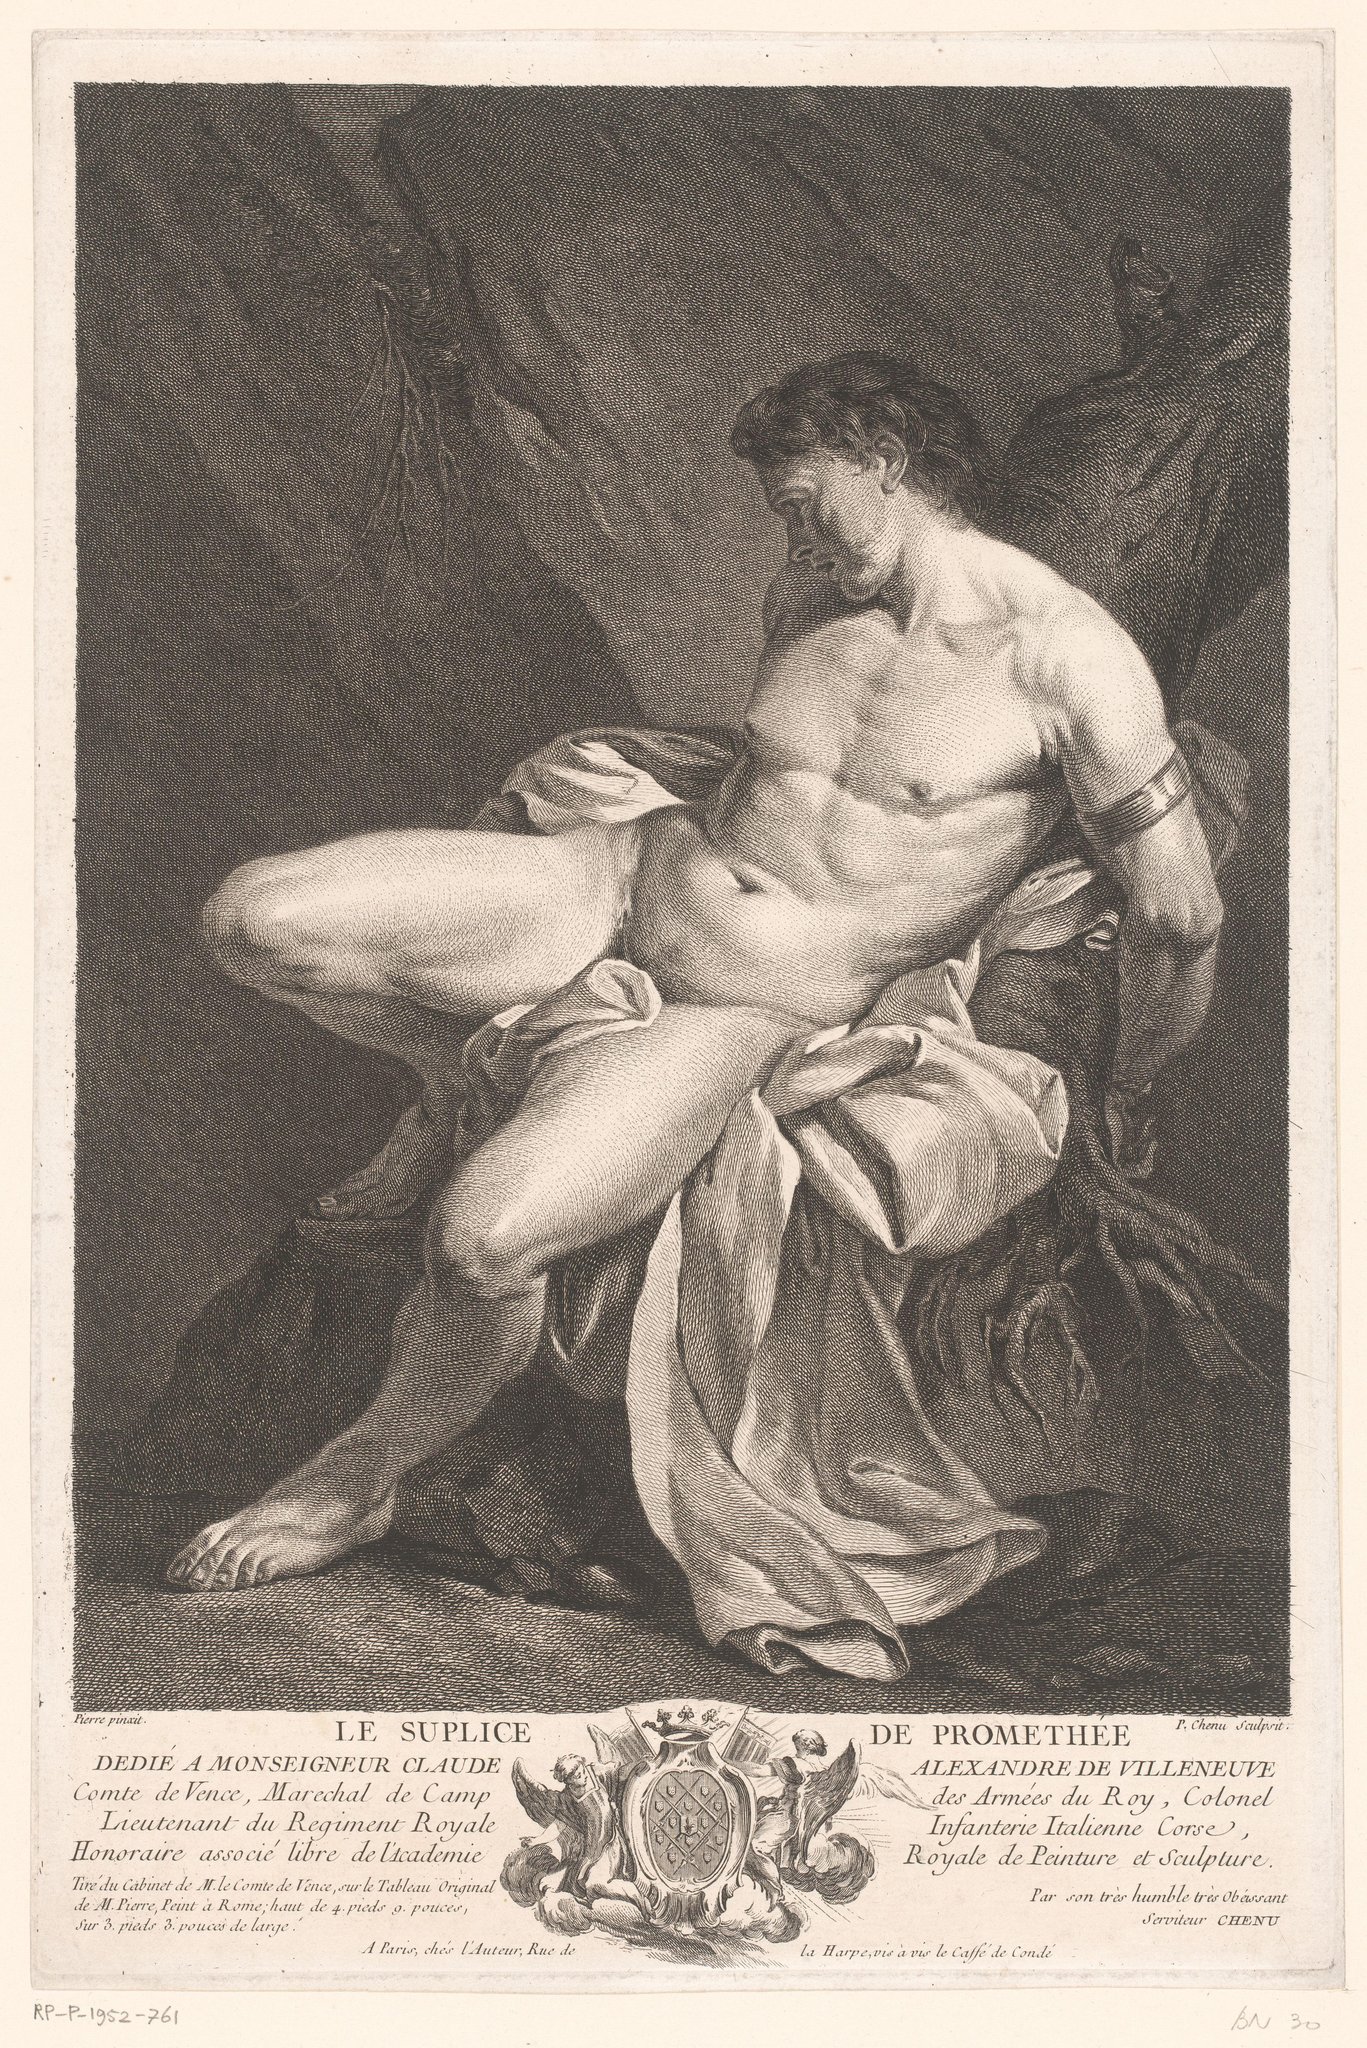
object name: print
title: Le suplice de Promethée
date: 1728-1760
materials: paper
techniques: engraving, etching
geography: rome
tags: punishment of prometheus; he is chained to a rock, usually by vulcan and/or mercury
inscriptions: collector's mark: Lugt 2228